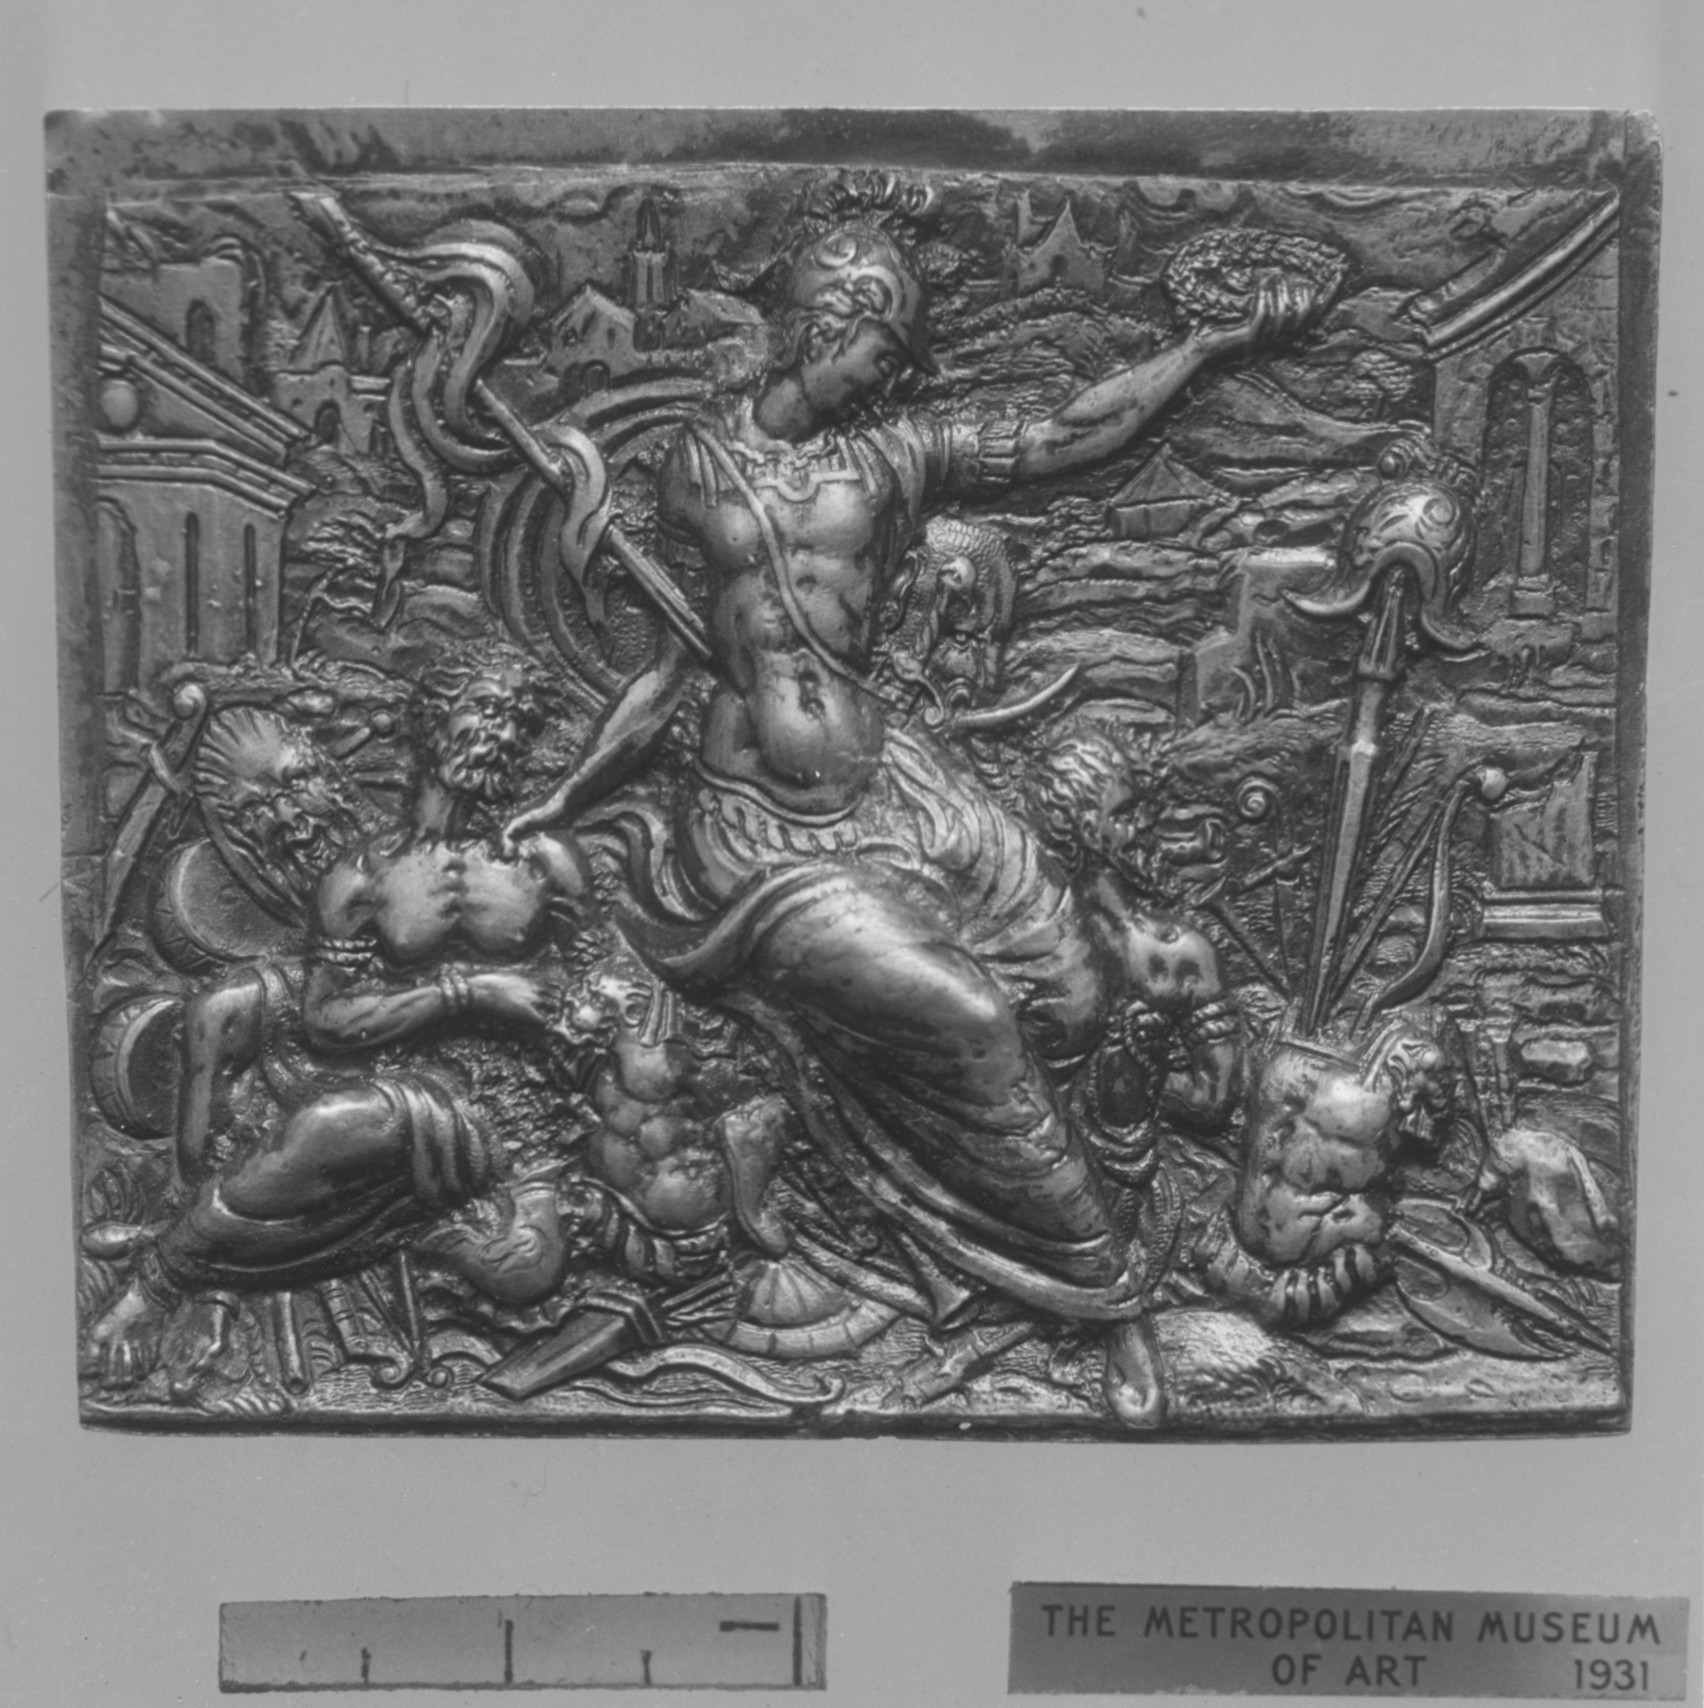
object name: plaquette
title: Bellona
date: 1567-1600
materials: silver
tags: armor,men